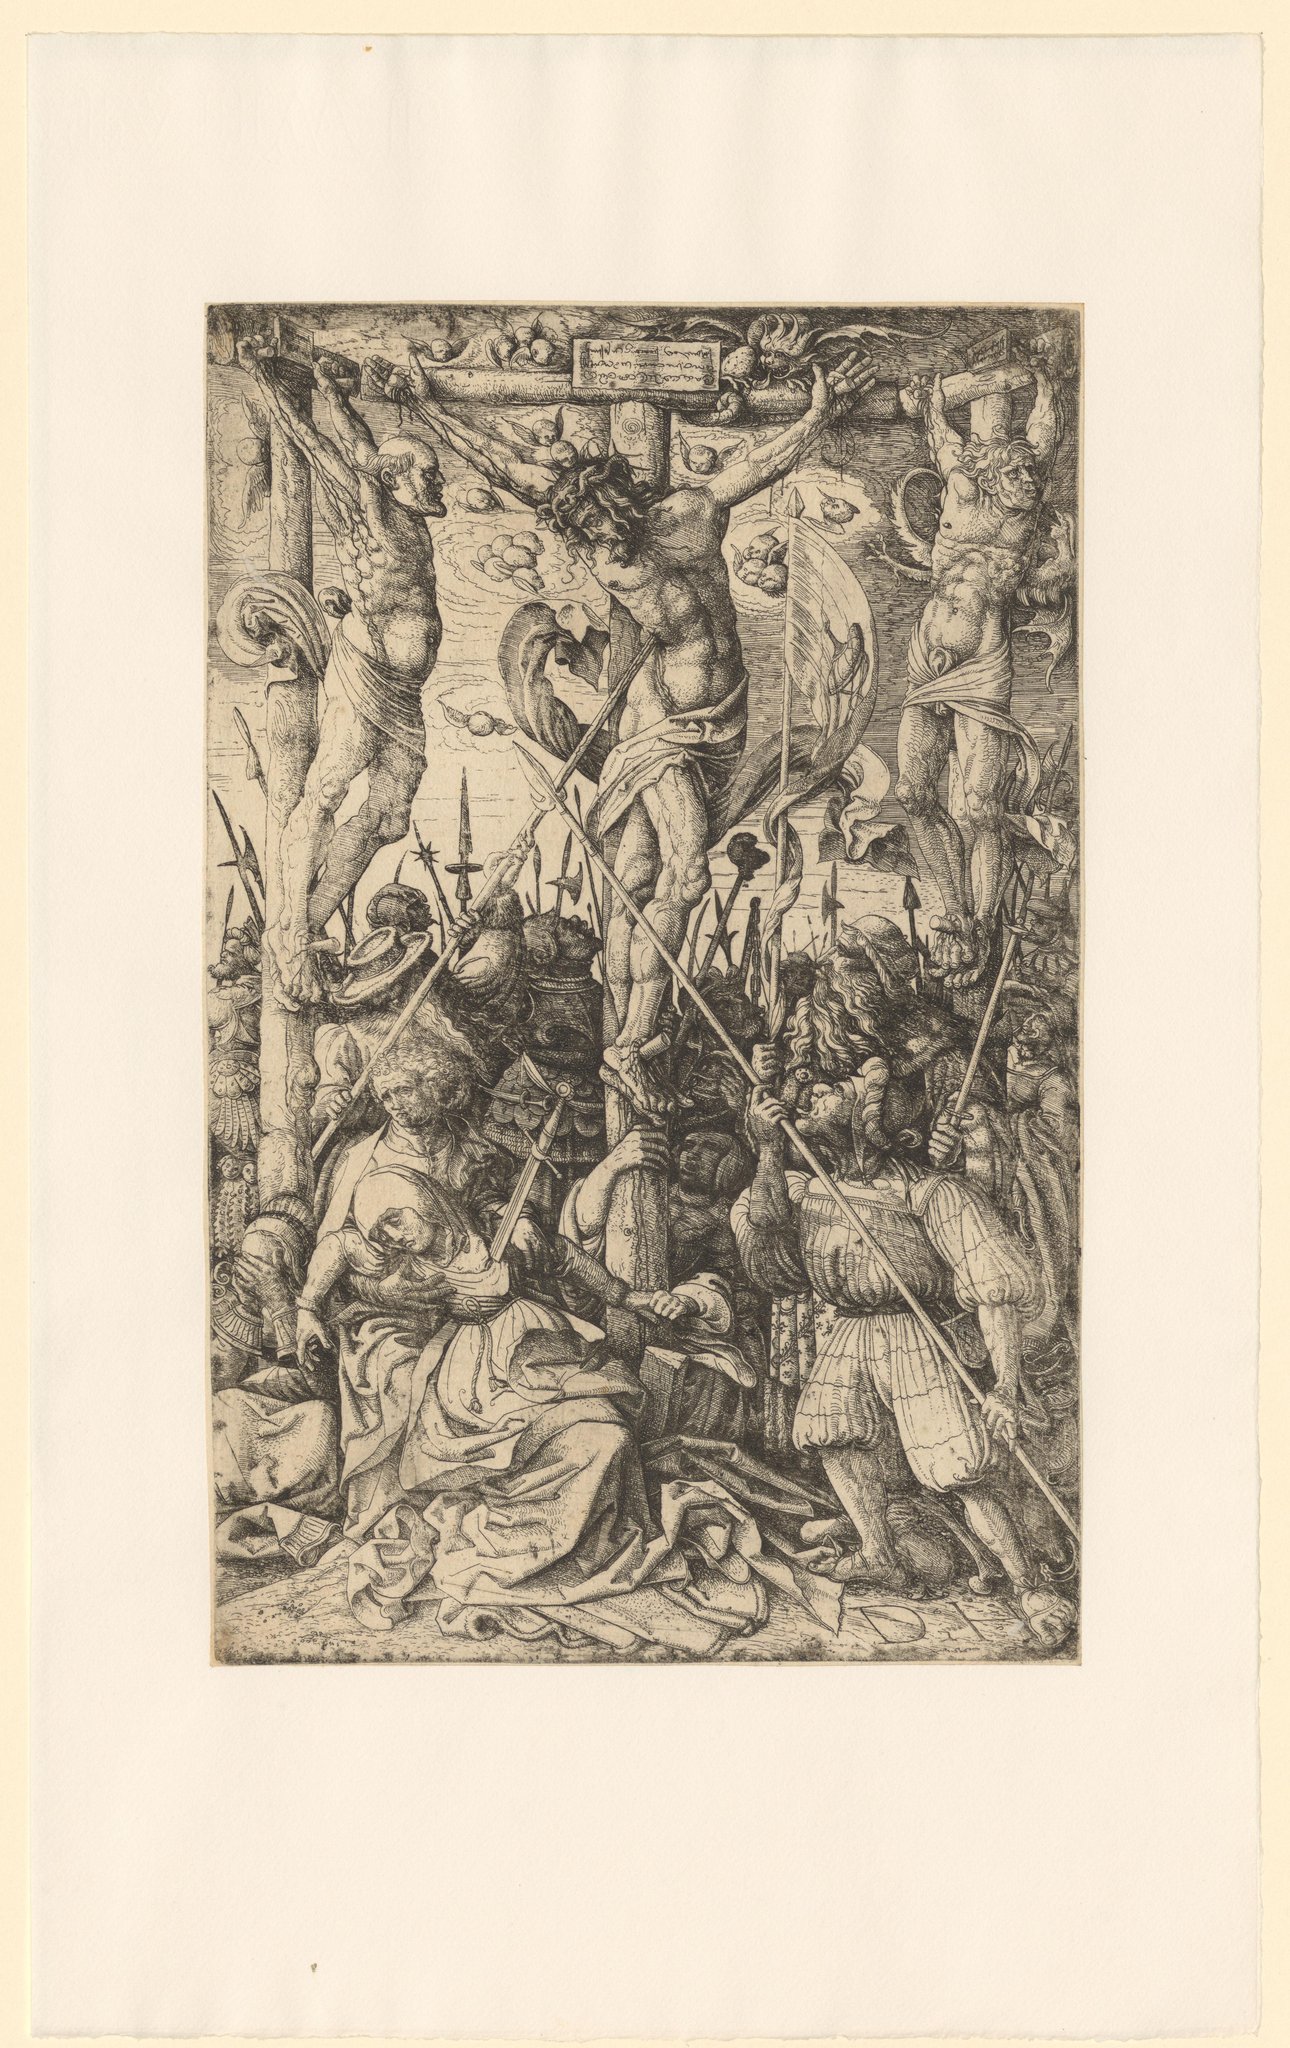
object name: print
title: Drie kruisen op Golgotha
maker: daniel hopfer (i)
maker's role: print maker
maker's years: 1470-1536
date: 1480-1536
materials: paper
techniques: etching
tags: crucified christ, with particular persons under the cross - dd - the three crosses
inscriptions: collector's mark: Lugt 2228